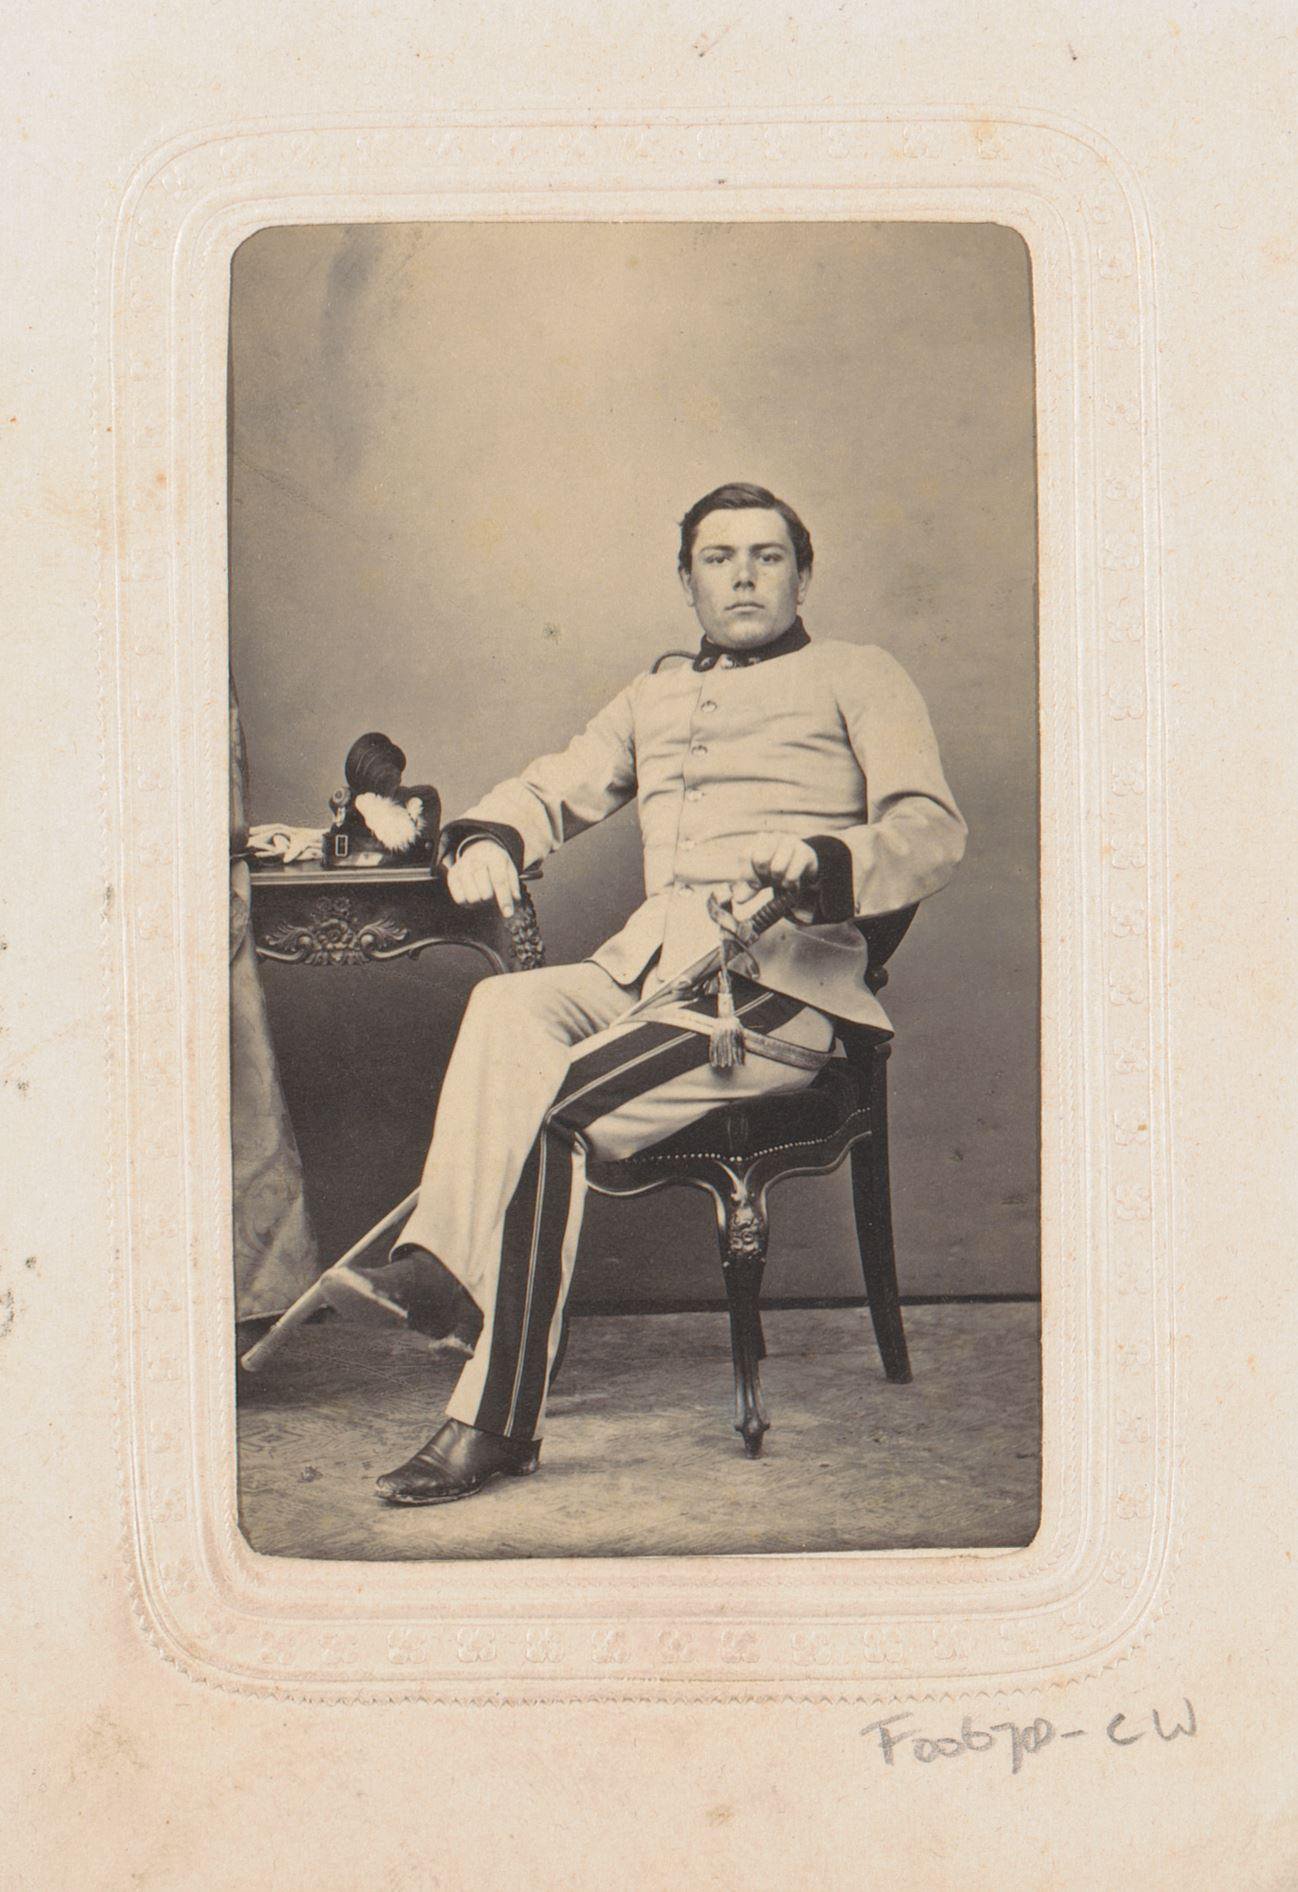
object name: photograph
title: Portret van een zittende militair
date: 1860-1880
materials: cardboard, photographic support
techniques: albumen print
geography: salzburg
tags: sitting figure, historical persons, (military) uniforms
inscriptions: inscription: ‘Baldi & Würthle/ photographisches anstalt/ Salzburg/ Riedenburg, Villa Baldi, No. 17’